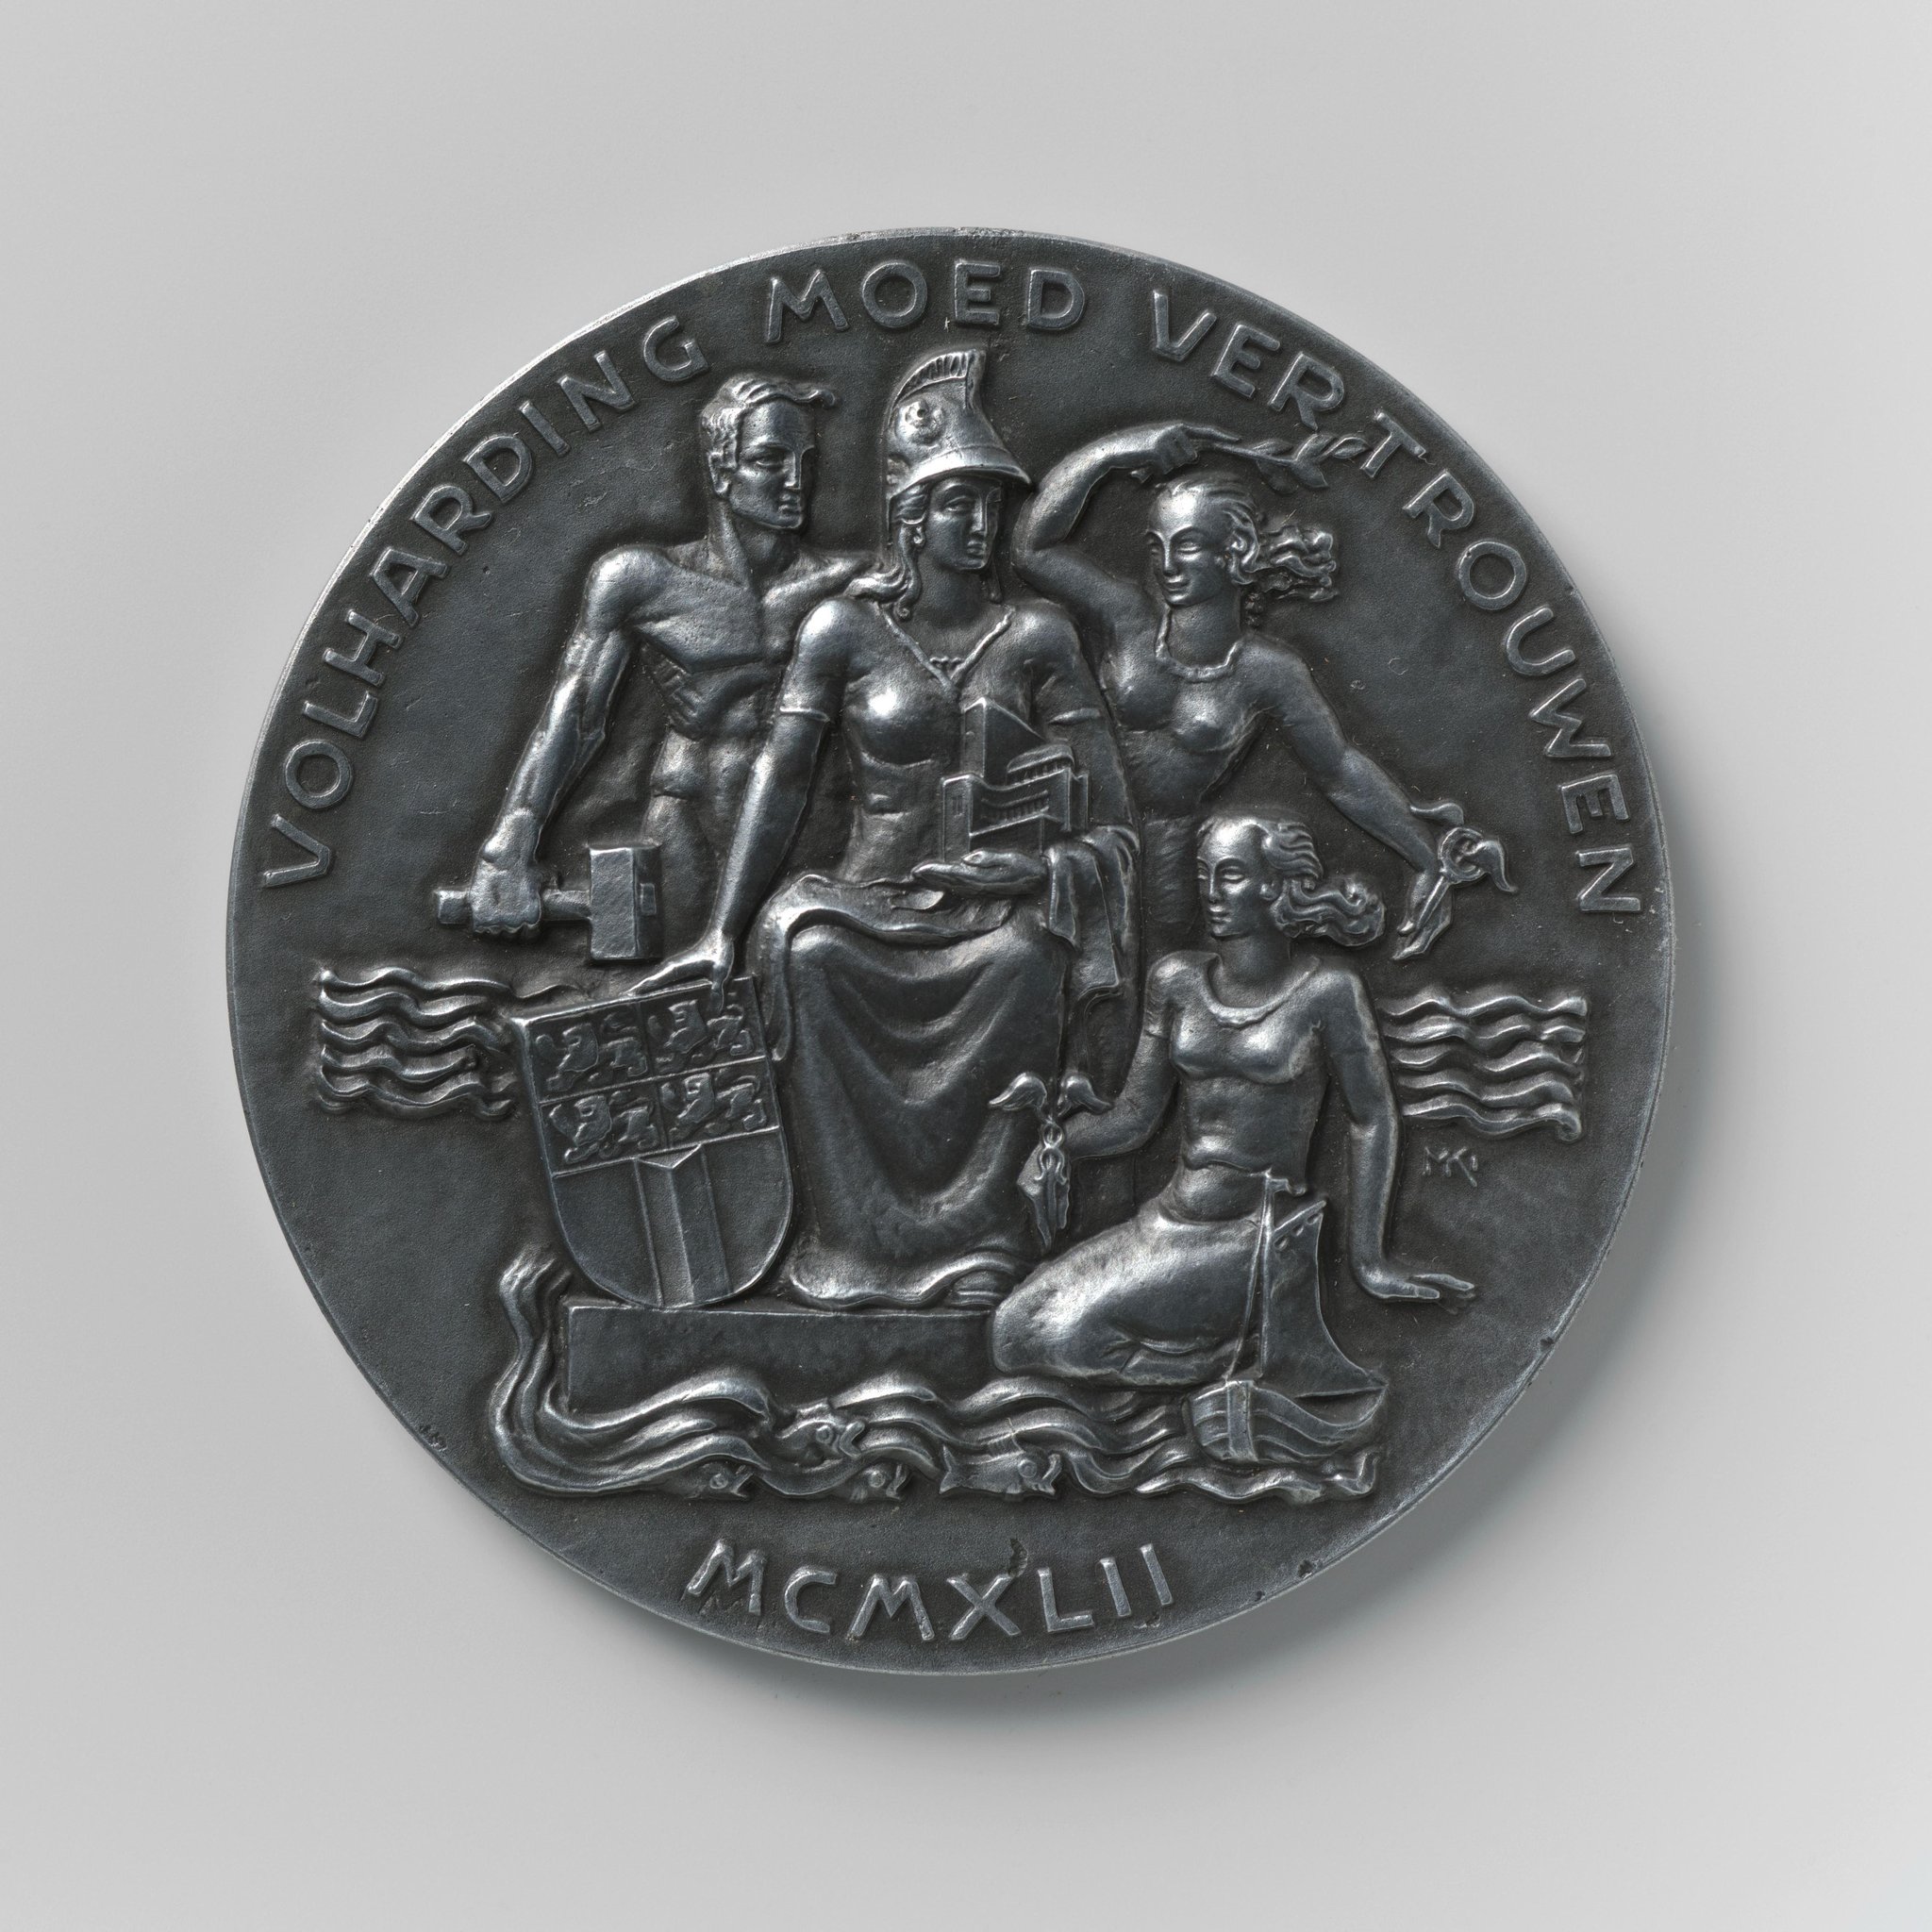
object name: history medal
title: Opening van de Maastunnel te Rotterdam (Vereniging voor Penningkunst 1942, jaarpenning)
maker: marinus kutterink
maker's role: sculptor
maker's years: 1907-1983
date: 1942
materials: metal alloy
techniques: striking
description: Witmetalen penning, op de voorzijde de Rotterdamse stadsgodin met wapenschild en maquette tronend tussen een man en twee vrouwen met symbolen van vrede, arbeid, handel en scheepvaart, met omschrift, op de keerzijde een plattegrond van het Nieuwe Maas-gebied met omschrift.